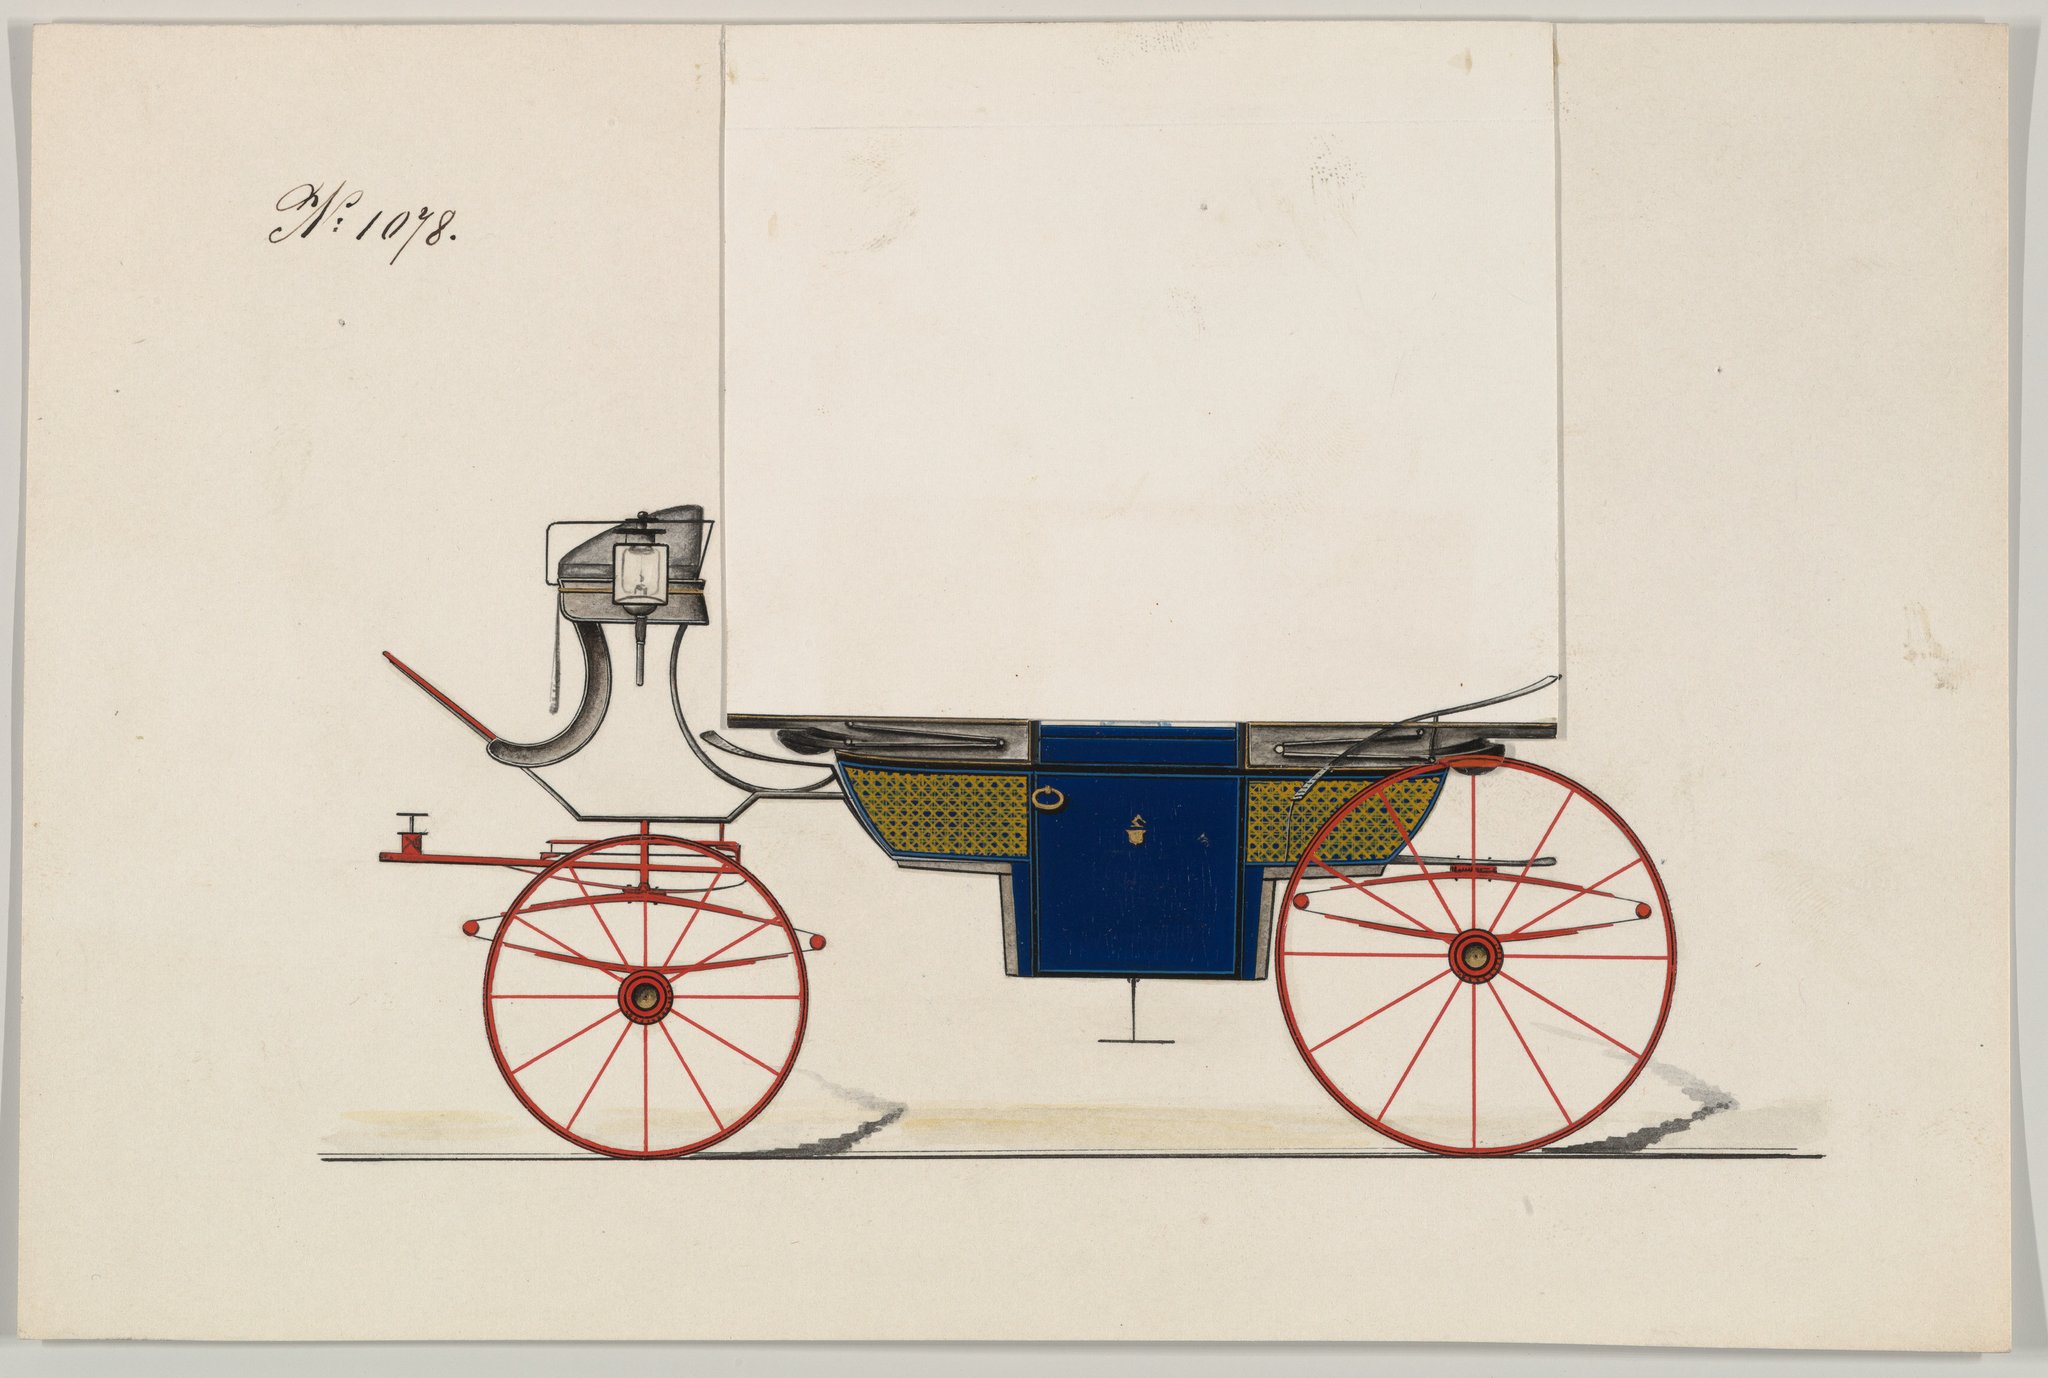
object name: drawing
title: Landau #1078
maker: brewster & co.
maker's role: manufacturer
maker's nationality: american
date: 1850-1870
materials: gouache, gum arabic, ink, watercolor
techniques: pen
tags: carriages